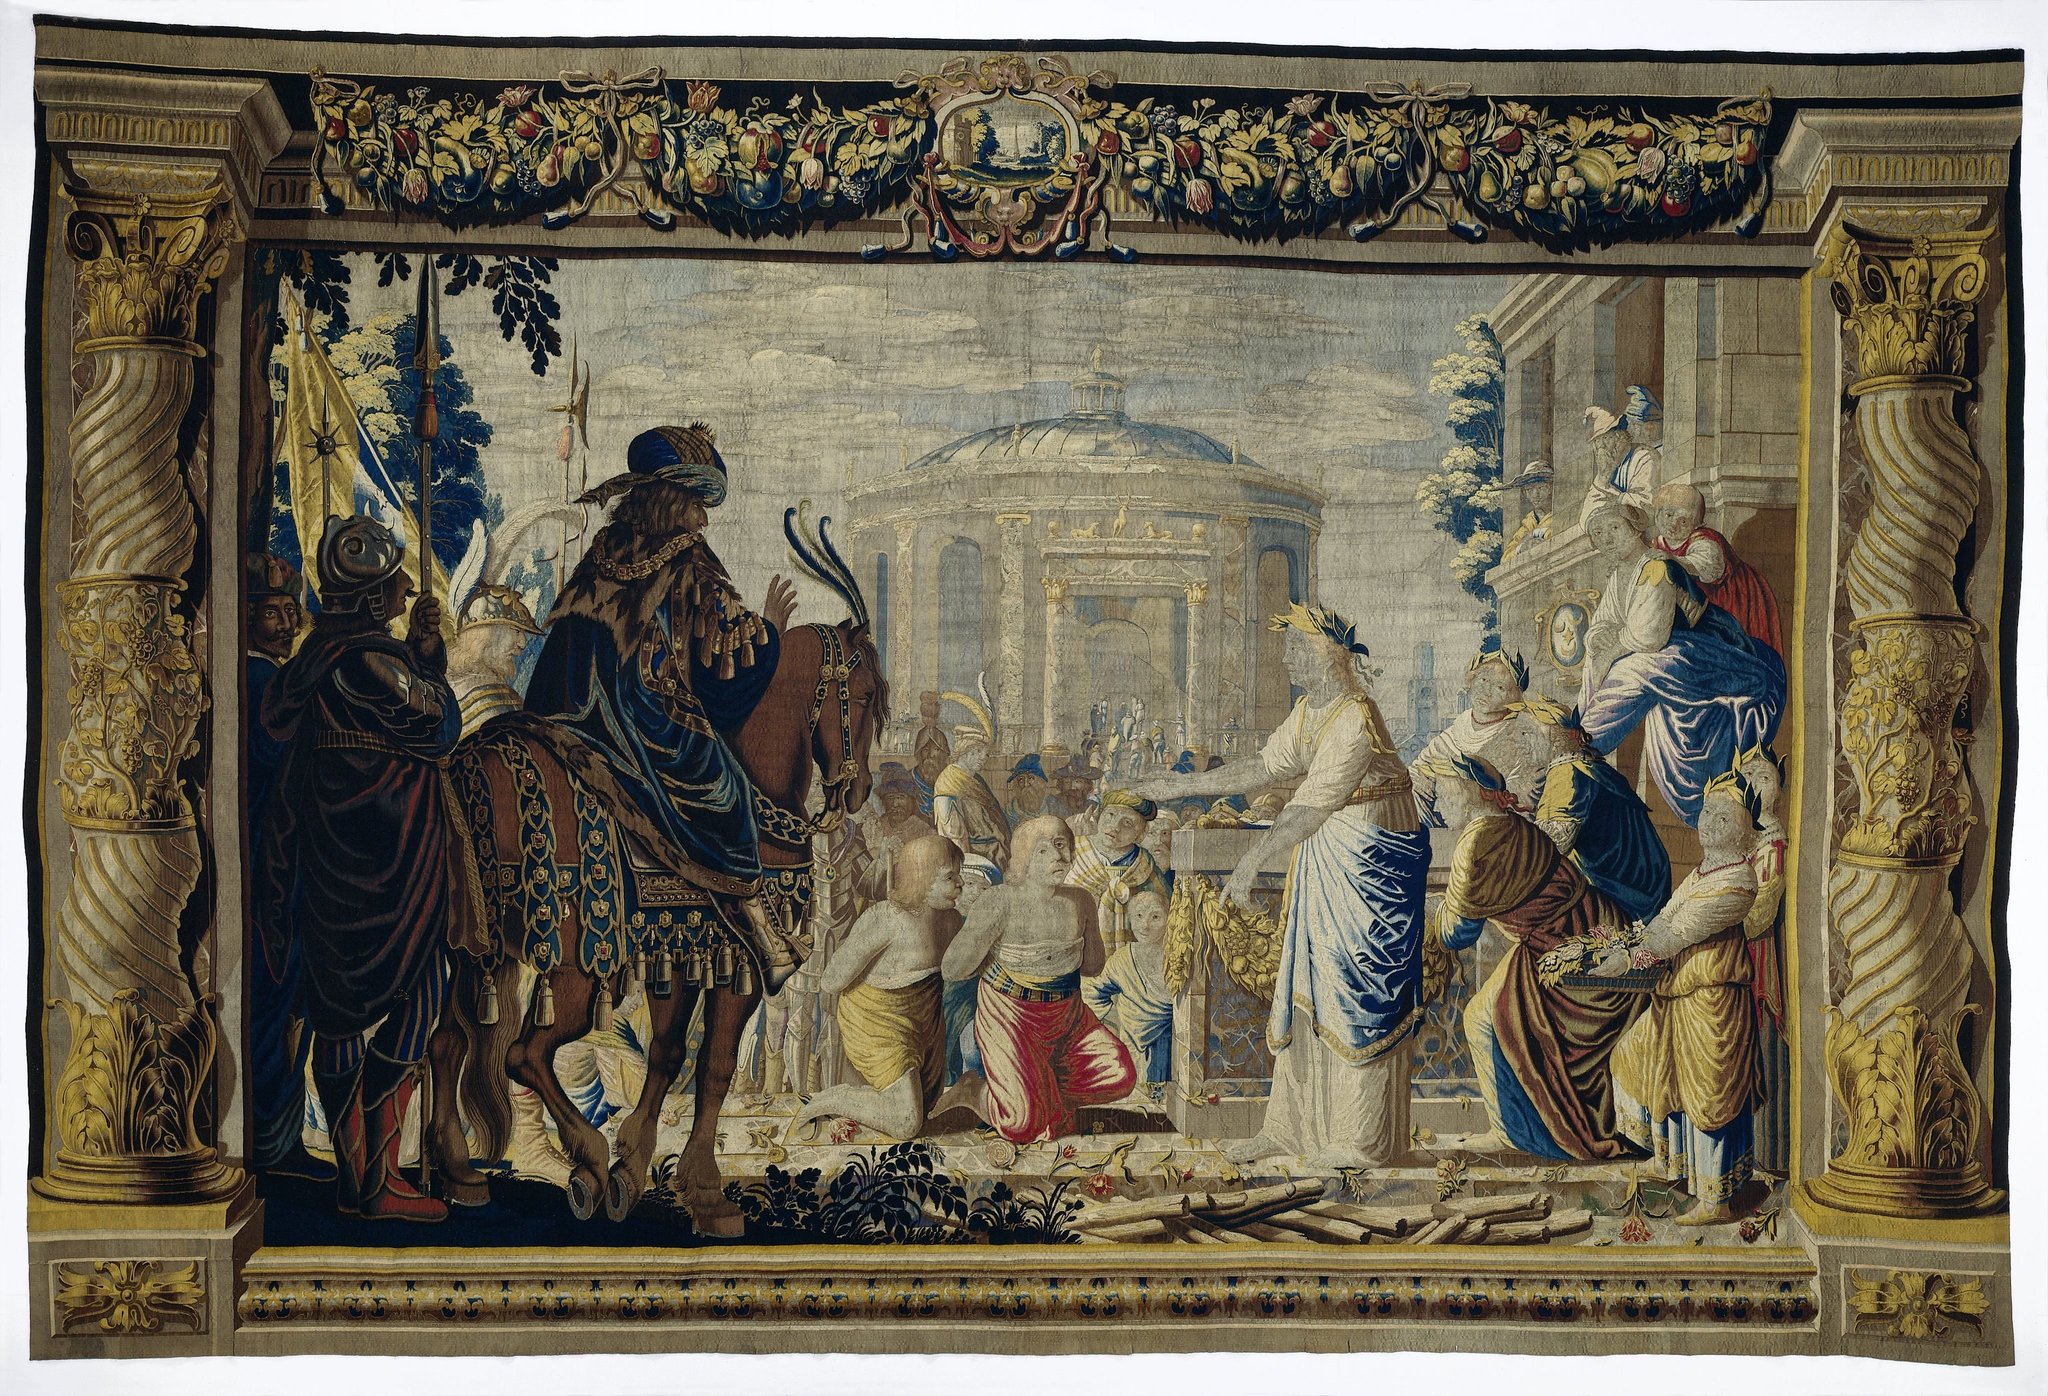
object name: tapestry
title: De geschiedenis van Iphigenia en Orestes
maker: salomon de bray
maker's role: draughtsman, print maker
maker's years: 1597-1664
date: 1648-1662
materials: silk, wool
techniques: tapestry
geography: northern netherlands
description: Wandtapijt met koning Thoas van Tauris die Iphigeneia beveelt de gevangen genomen Orestes en Pylades aan Artemis te offeren; uit een serie van vijf wandtapijten met voorstellingen ontleend aan Iphigeneia op Tauris van Euripides.